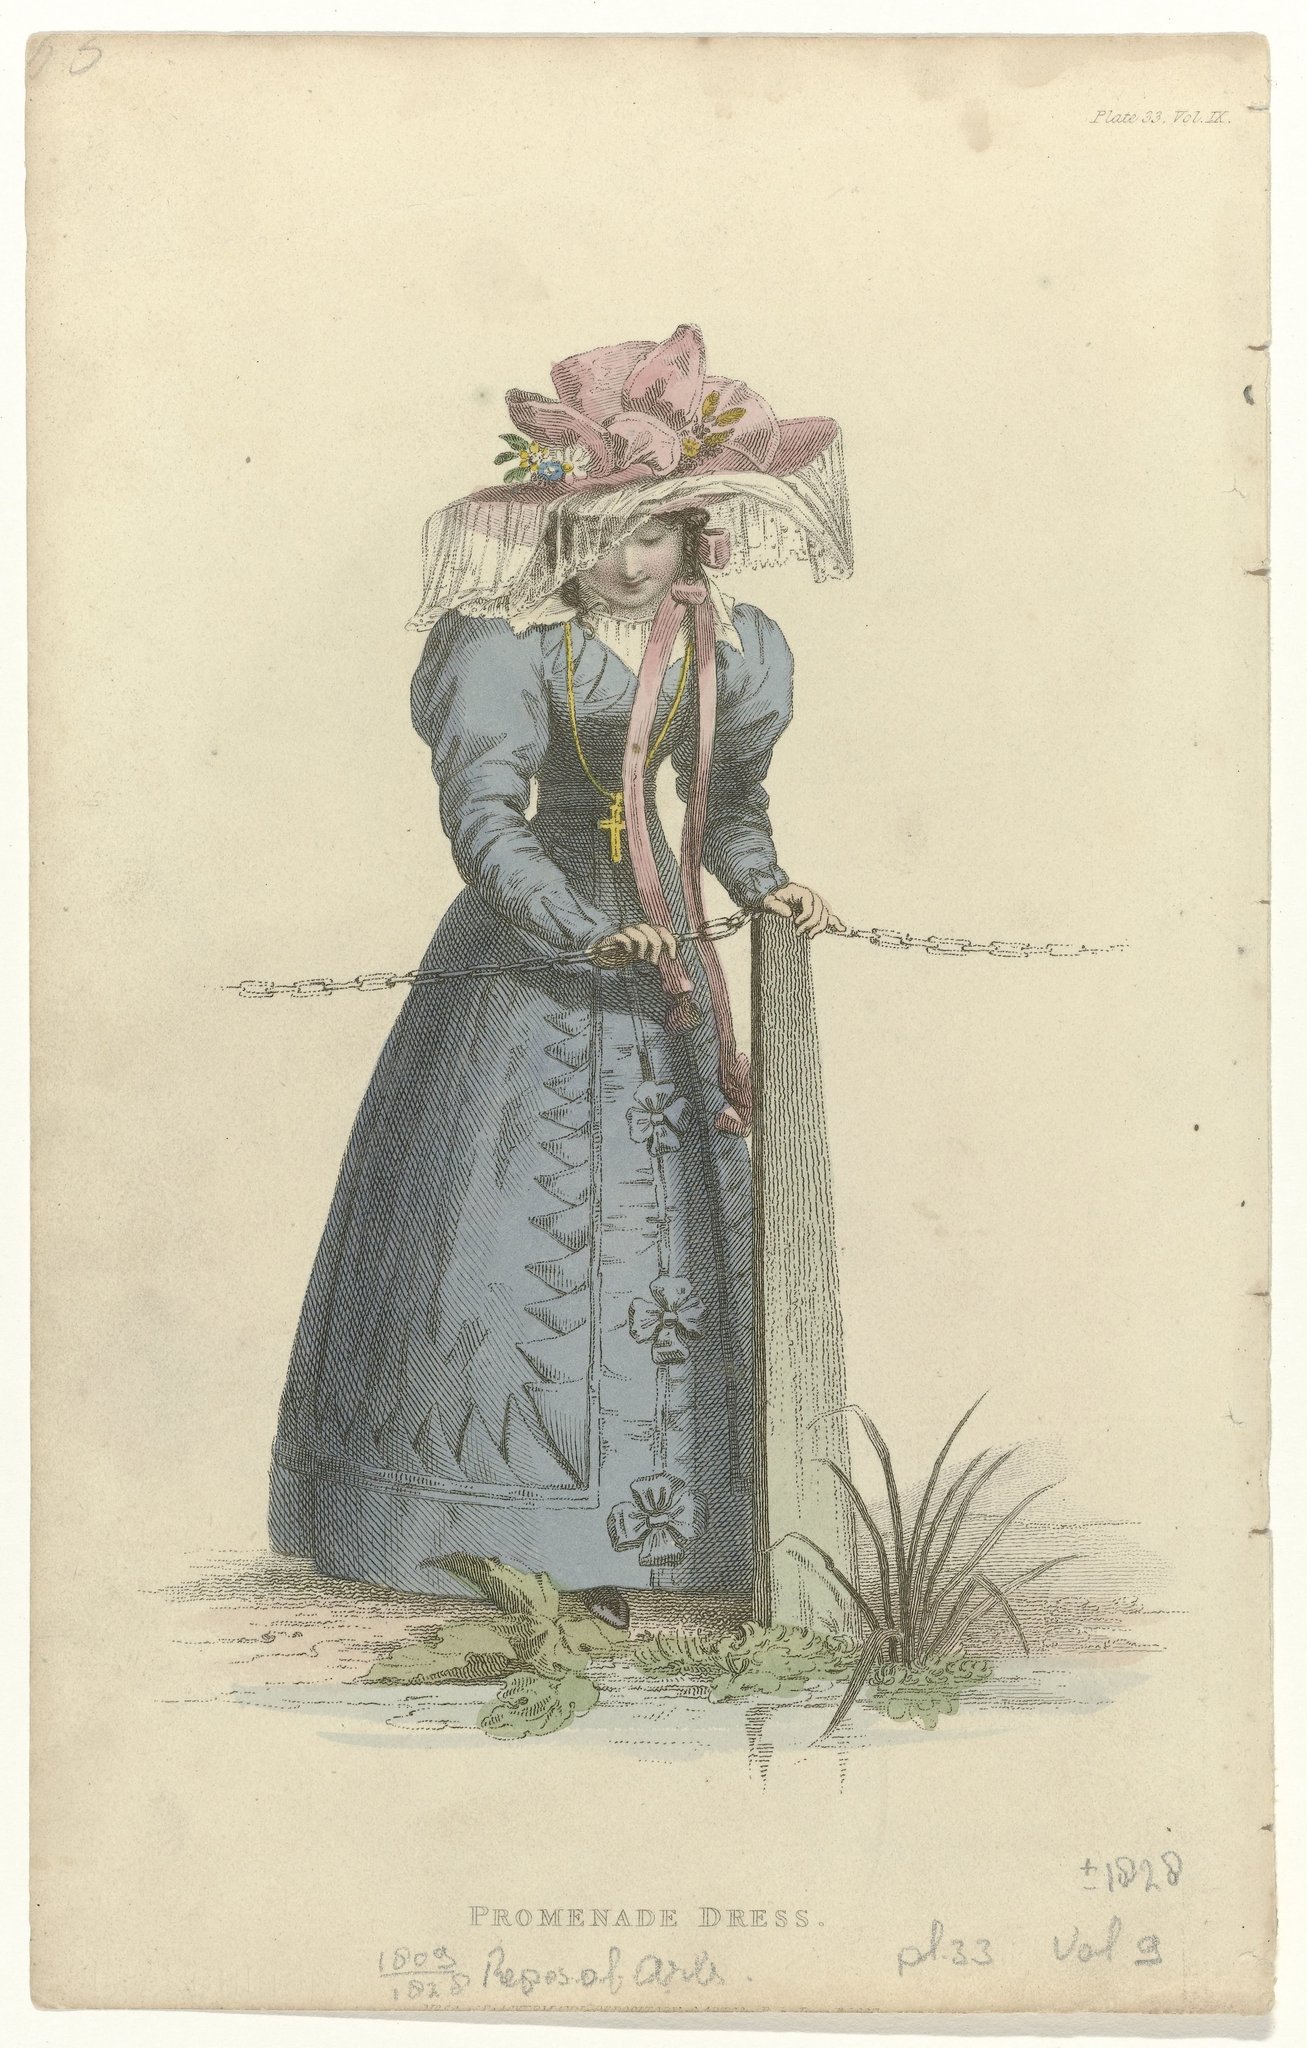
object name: fashion print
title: Ackermann's Repository of Arts, ca. 1828, Pl. 33, Vol. 9: Promenade Dress.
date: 1828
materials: paper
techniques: etching, hand coloring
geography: london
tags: pendant, trinket, 'breloque' (+ women's clothes), dress, gown: walking dress (+ women's clothes), fashion plates, head-gear: hat (+ women's clothes), gloves, mittens, etc. (+ women's clothes)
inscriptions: title: ‘Promenade dress.’